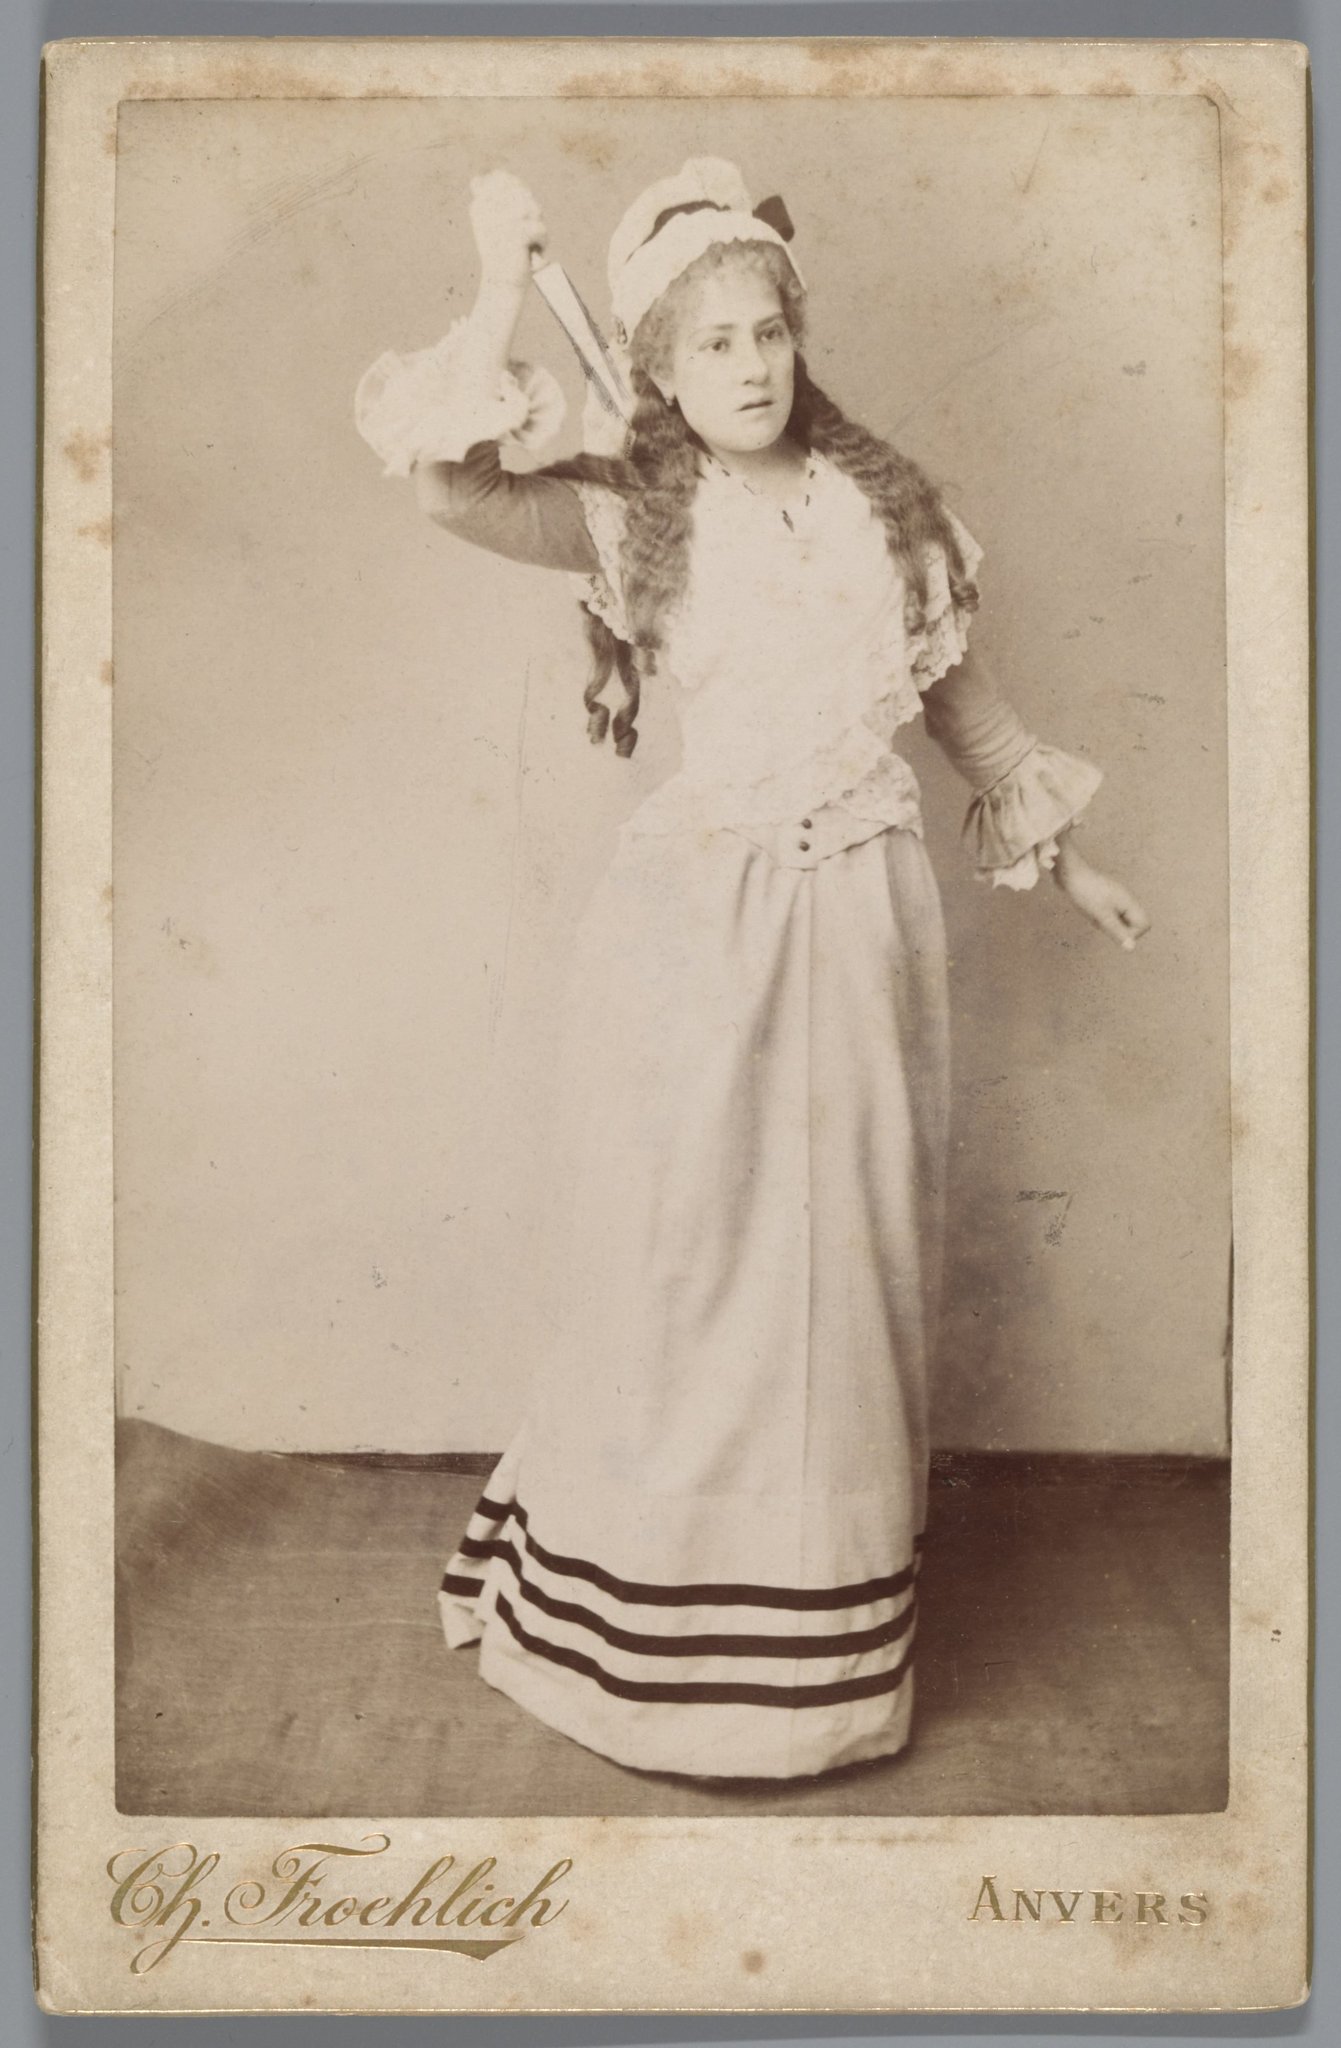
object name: cabinet photograph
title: Julia Cuypers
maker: carl froehlich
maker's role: fotograaf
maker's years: 1854-1902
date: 1860-1915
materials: cardboard, paper, photographic support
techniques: gelatin silver print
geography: netherlands